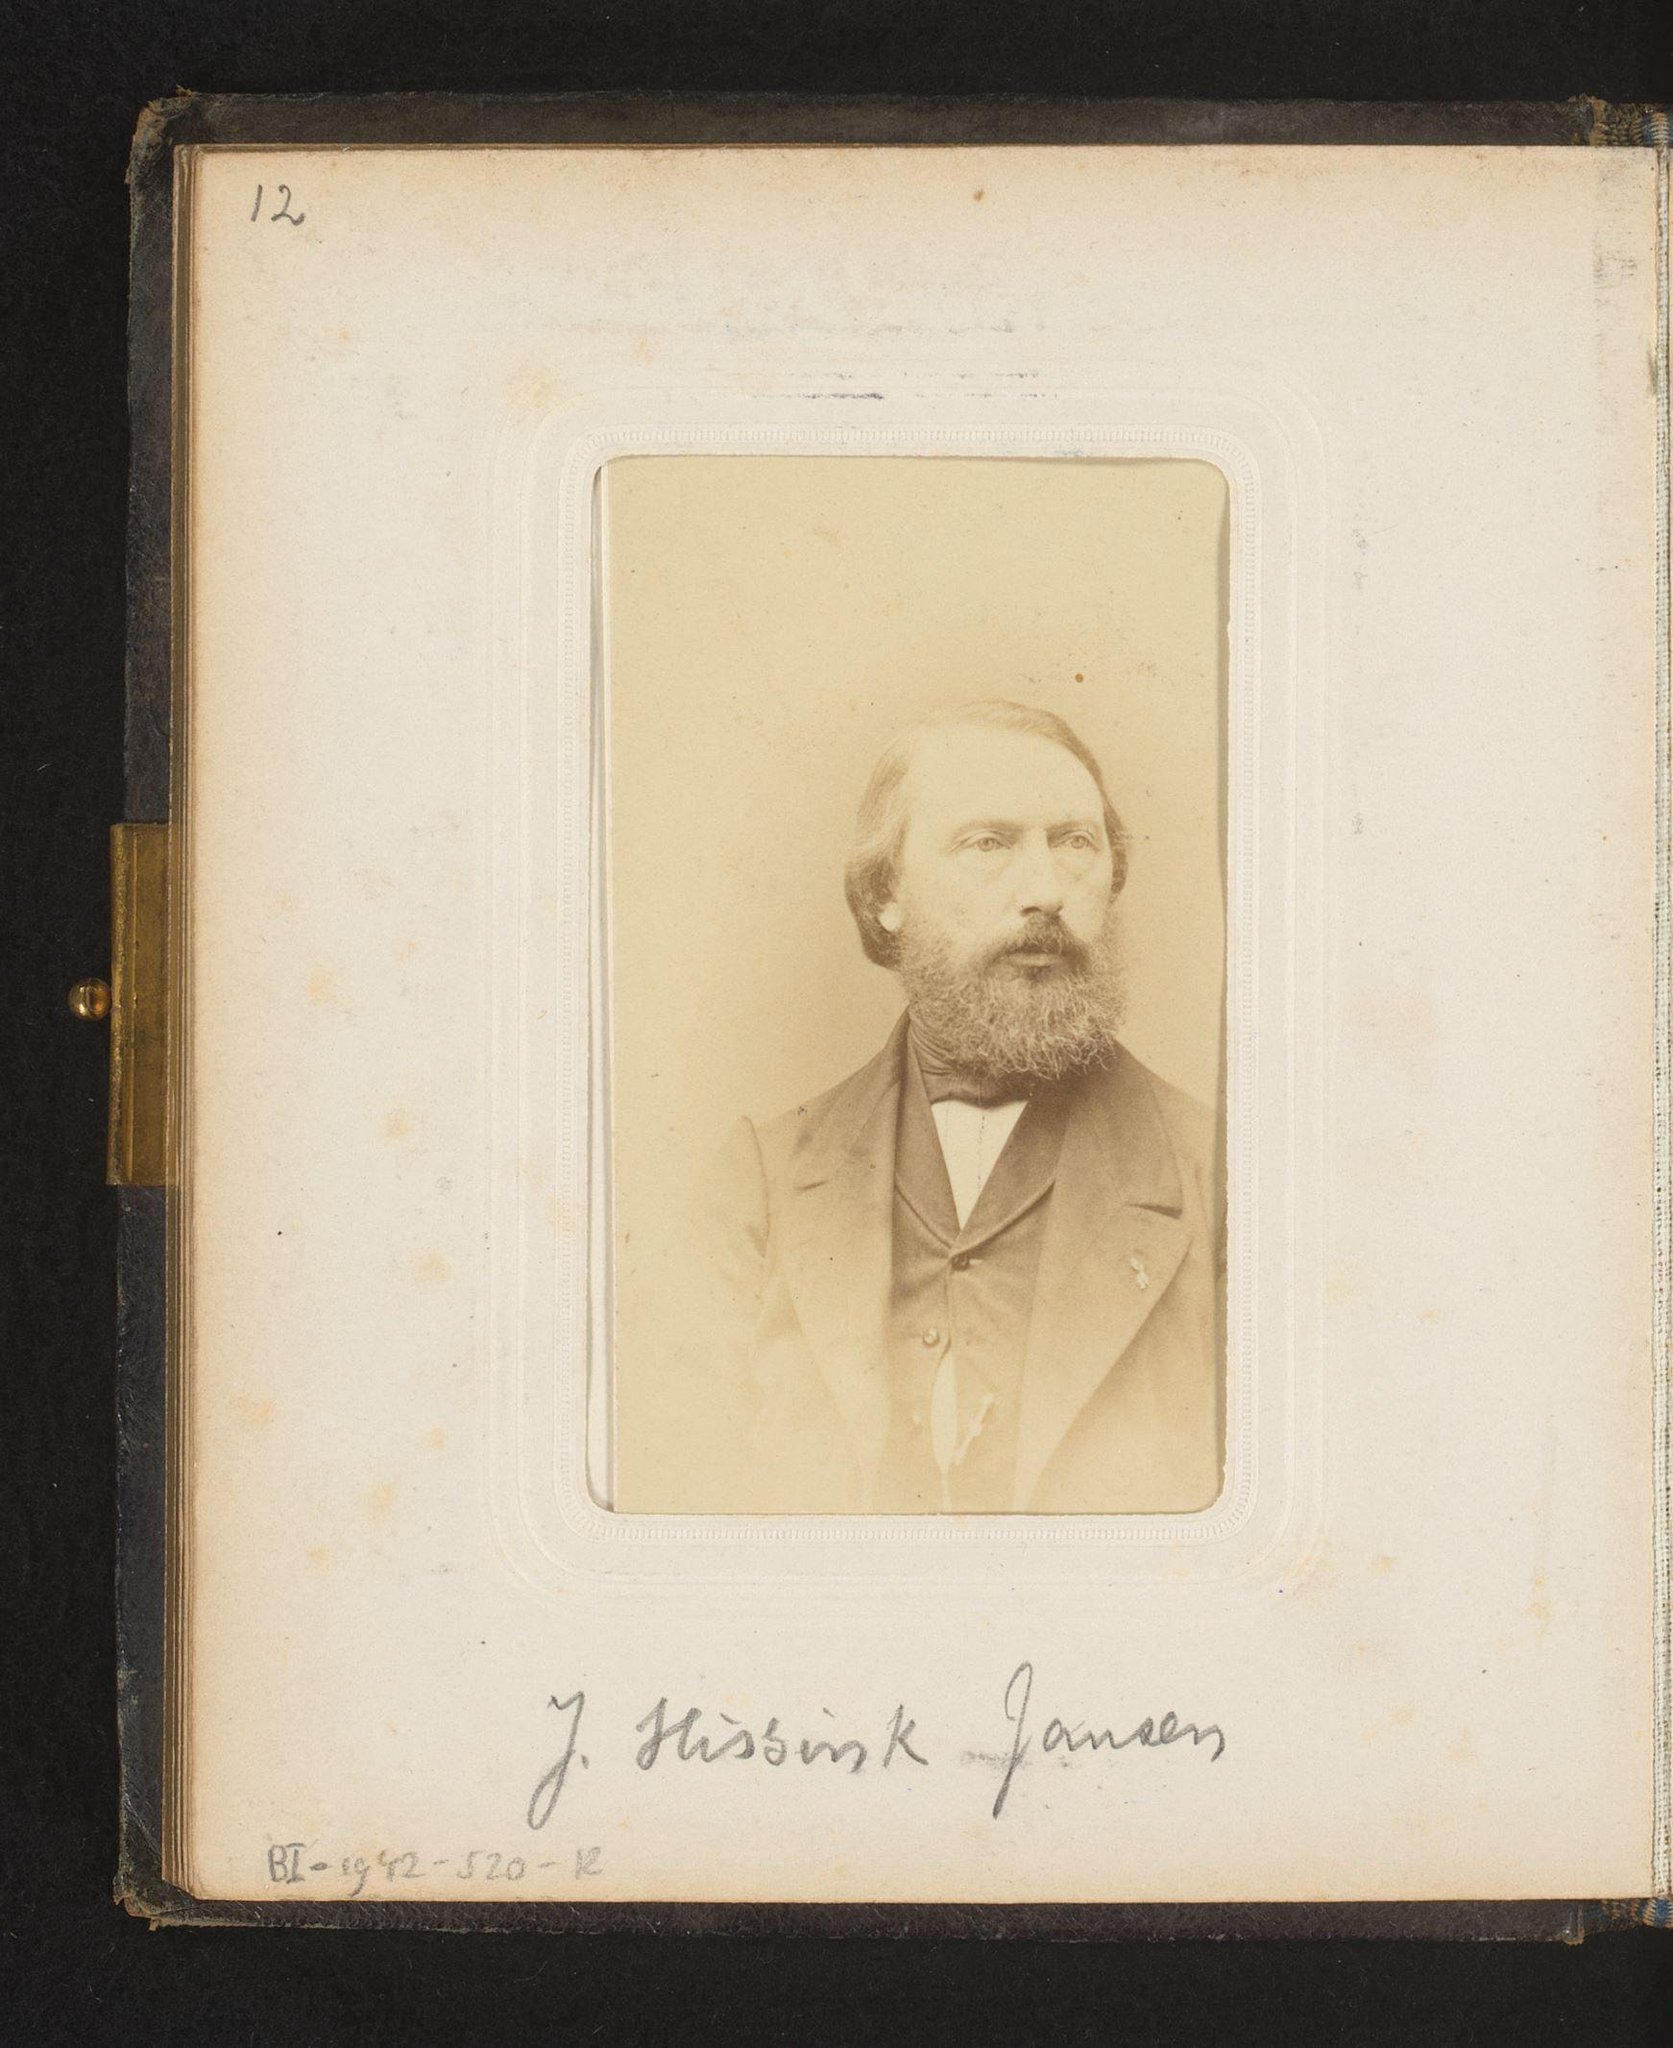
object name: carte de visite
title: J. Hissink Jansen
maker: johannes hinderikus egenberger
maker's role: draughtsman, print maker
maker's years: 1822-1897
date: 1864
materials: cardboard, paper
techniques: albumen print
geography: groningen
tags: historical persons, professor, groningen (province)